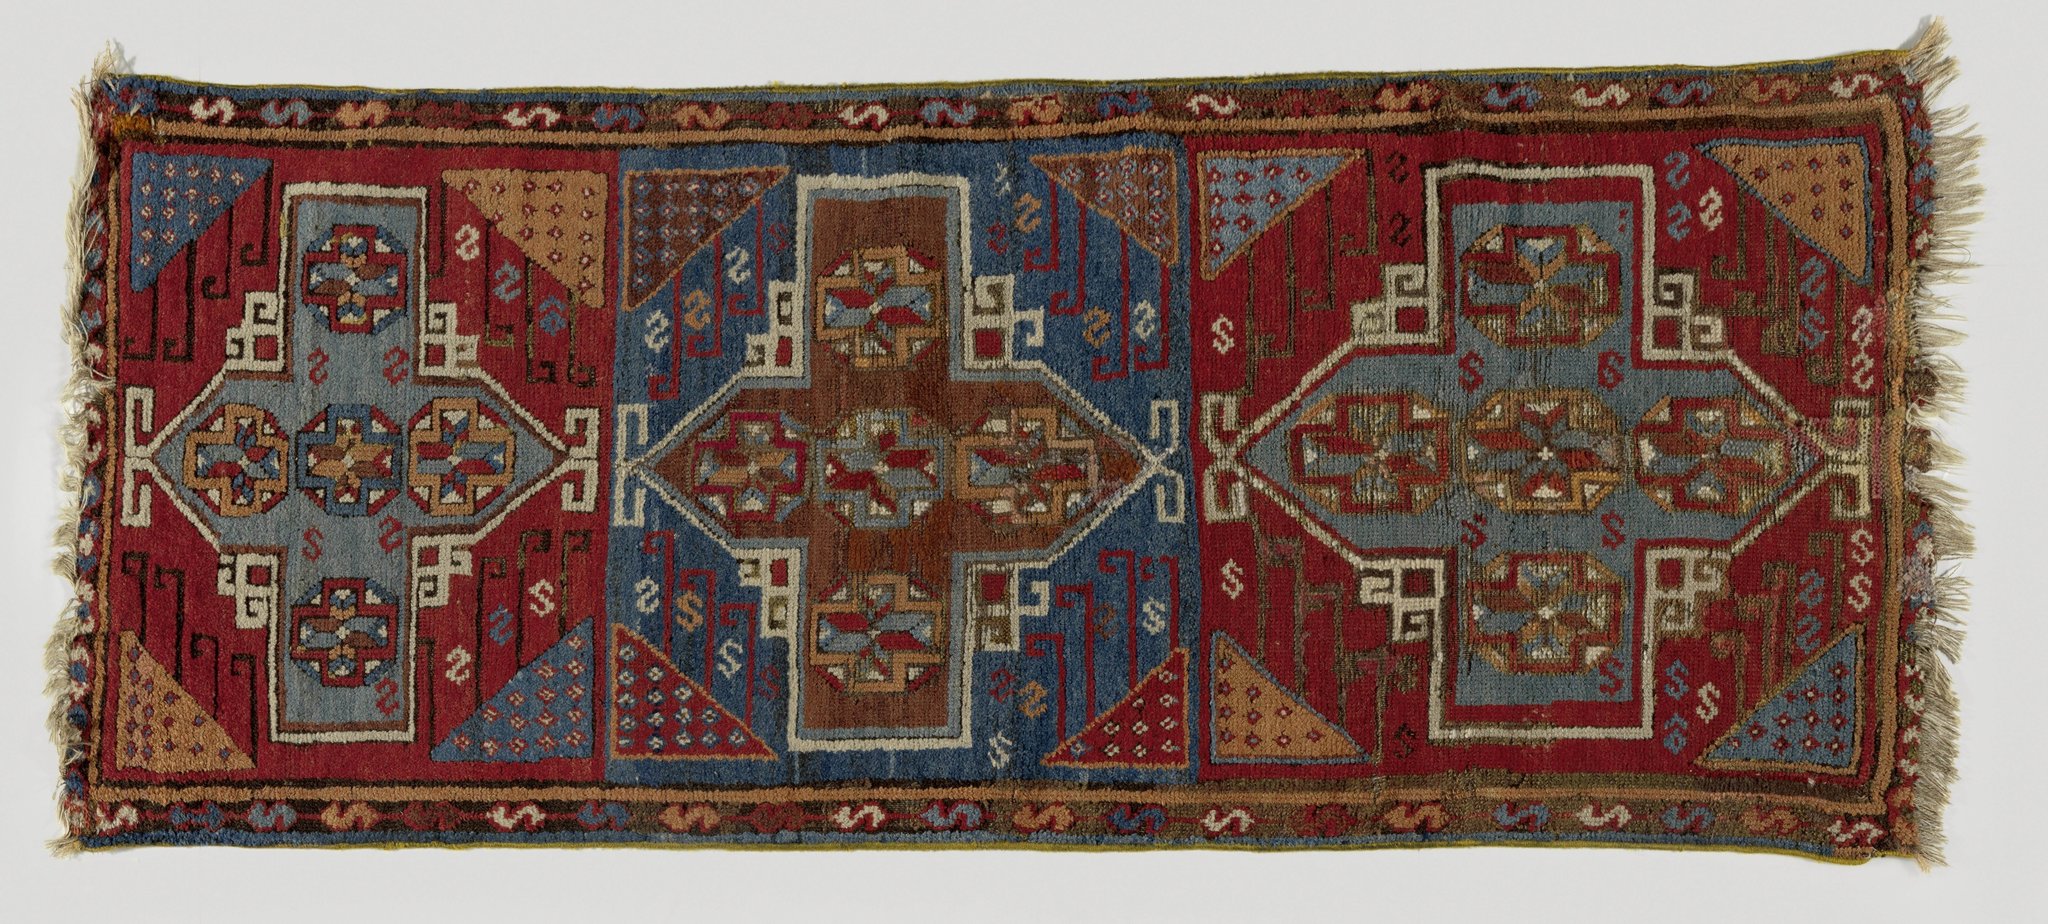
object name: oriental rug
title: Perkenkleed of tuinkleed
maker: Anonymous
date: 1850-1900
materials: wool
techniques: ghiordes knot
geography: kemerihisar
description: Perken- of tuinkleed. Middenveld: indeling van drie rechthoeken, de middelste in kobaltblauw en twee in rood, waarop kruismedaillons staan aangevuld met driehoeken als zwikken. De kruisen, lichtblauw en bruin, zijn wit gerand, elk gvuld met sterbloemen die in een kruis of in een achthoek gevat staan; de bloemen in oranje, rood, blauw en wit. De driehoeken zijn bestrooid met bloesems en van de lange zijden daarvan schieten lange liggende haken naar het midden uit. Rand: één smalle zoom van zwart met aaneengeregen S-sen in wit, blauw, oranje en bruin, binnen effen biezen.